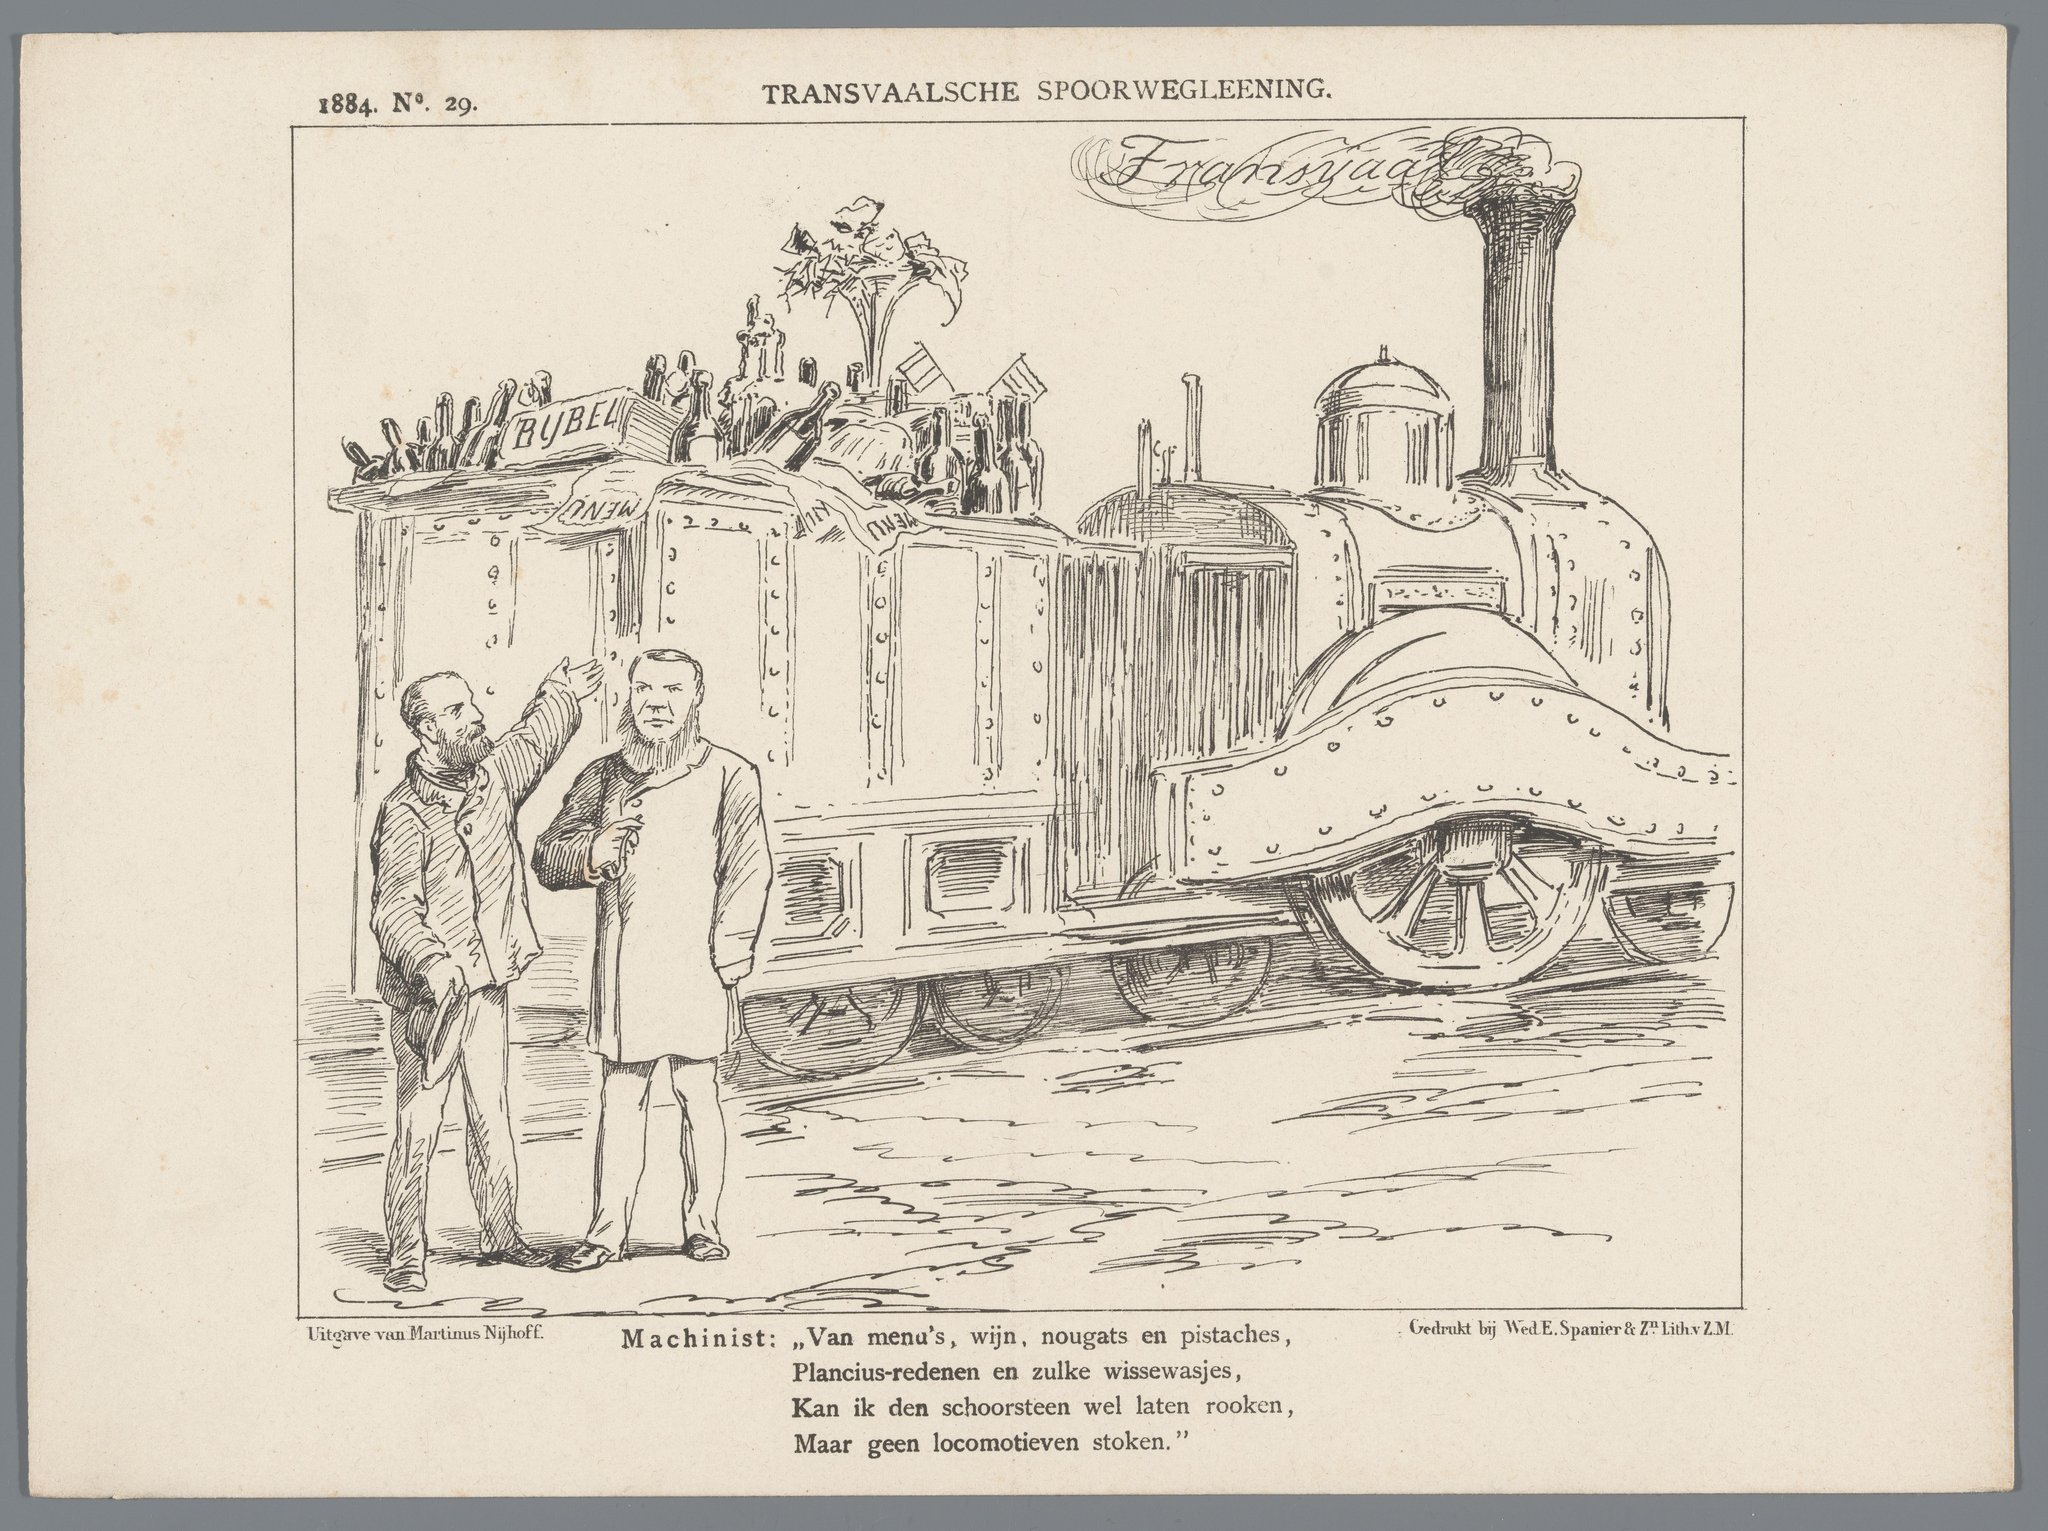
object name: print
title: Spotprent op de Transvaalse spoorweglening, 1884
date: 1884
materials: paper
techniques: lithograph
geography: the hague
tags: steam locomotive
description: Spotprent op de Transvaalse spoorweglening. Paul Kruger voor een locomotief aangesproken door een machinist. Plaat verschenen bij het weekblad De Nederlandsche Spectator, nr. 29, 1884.